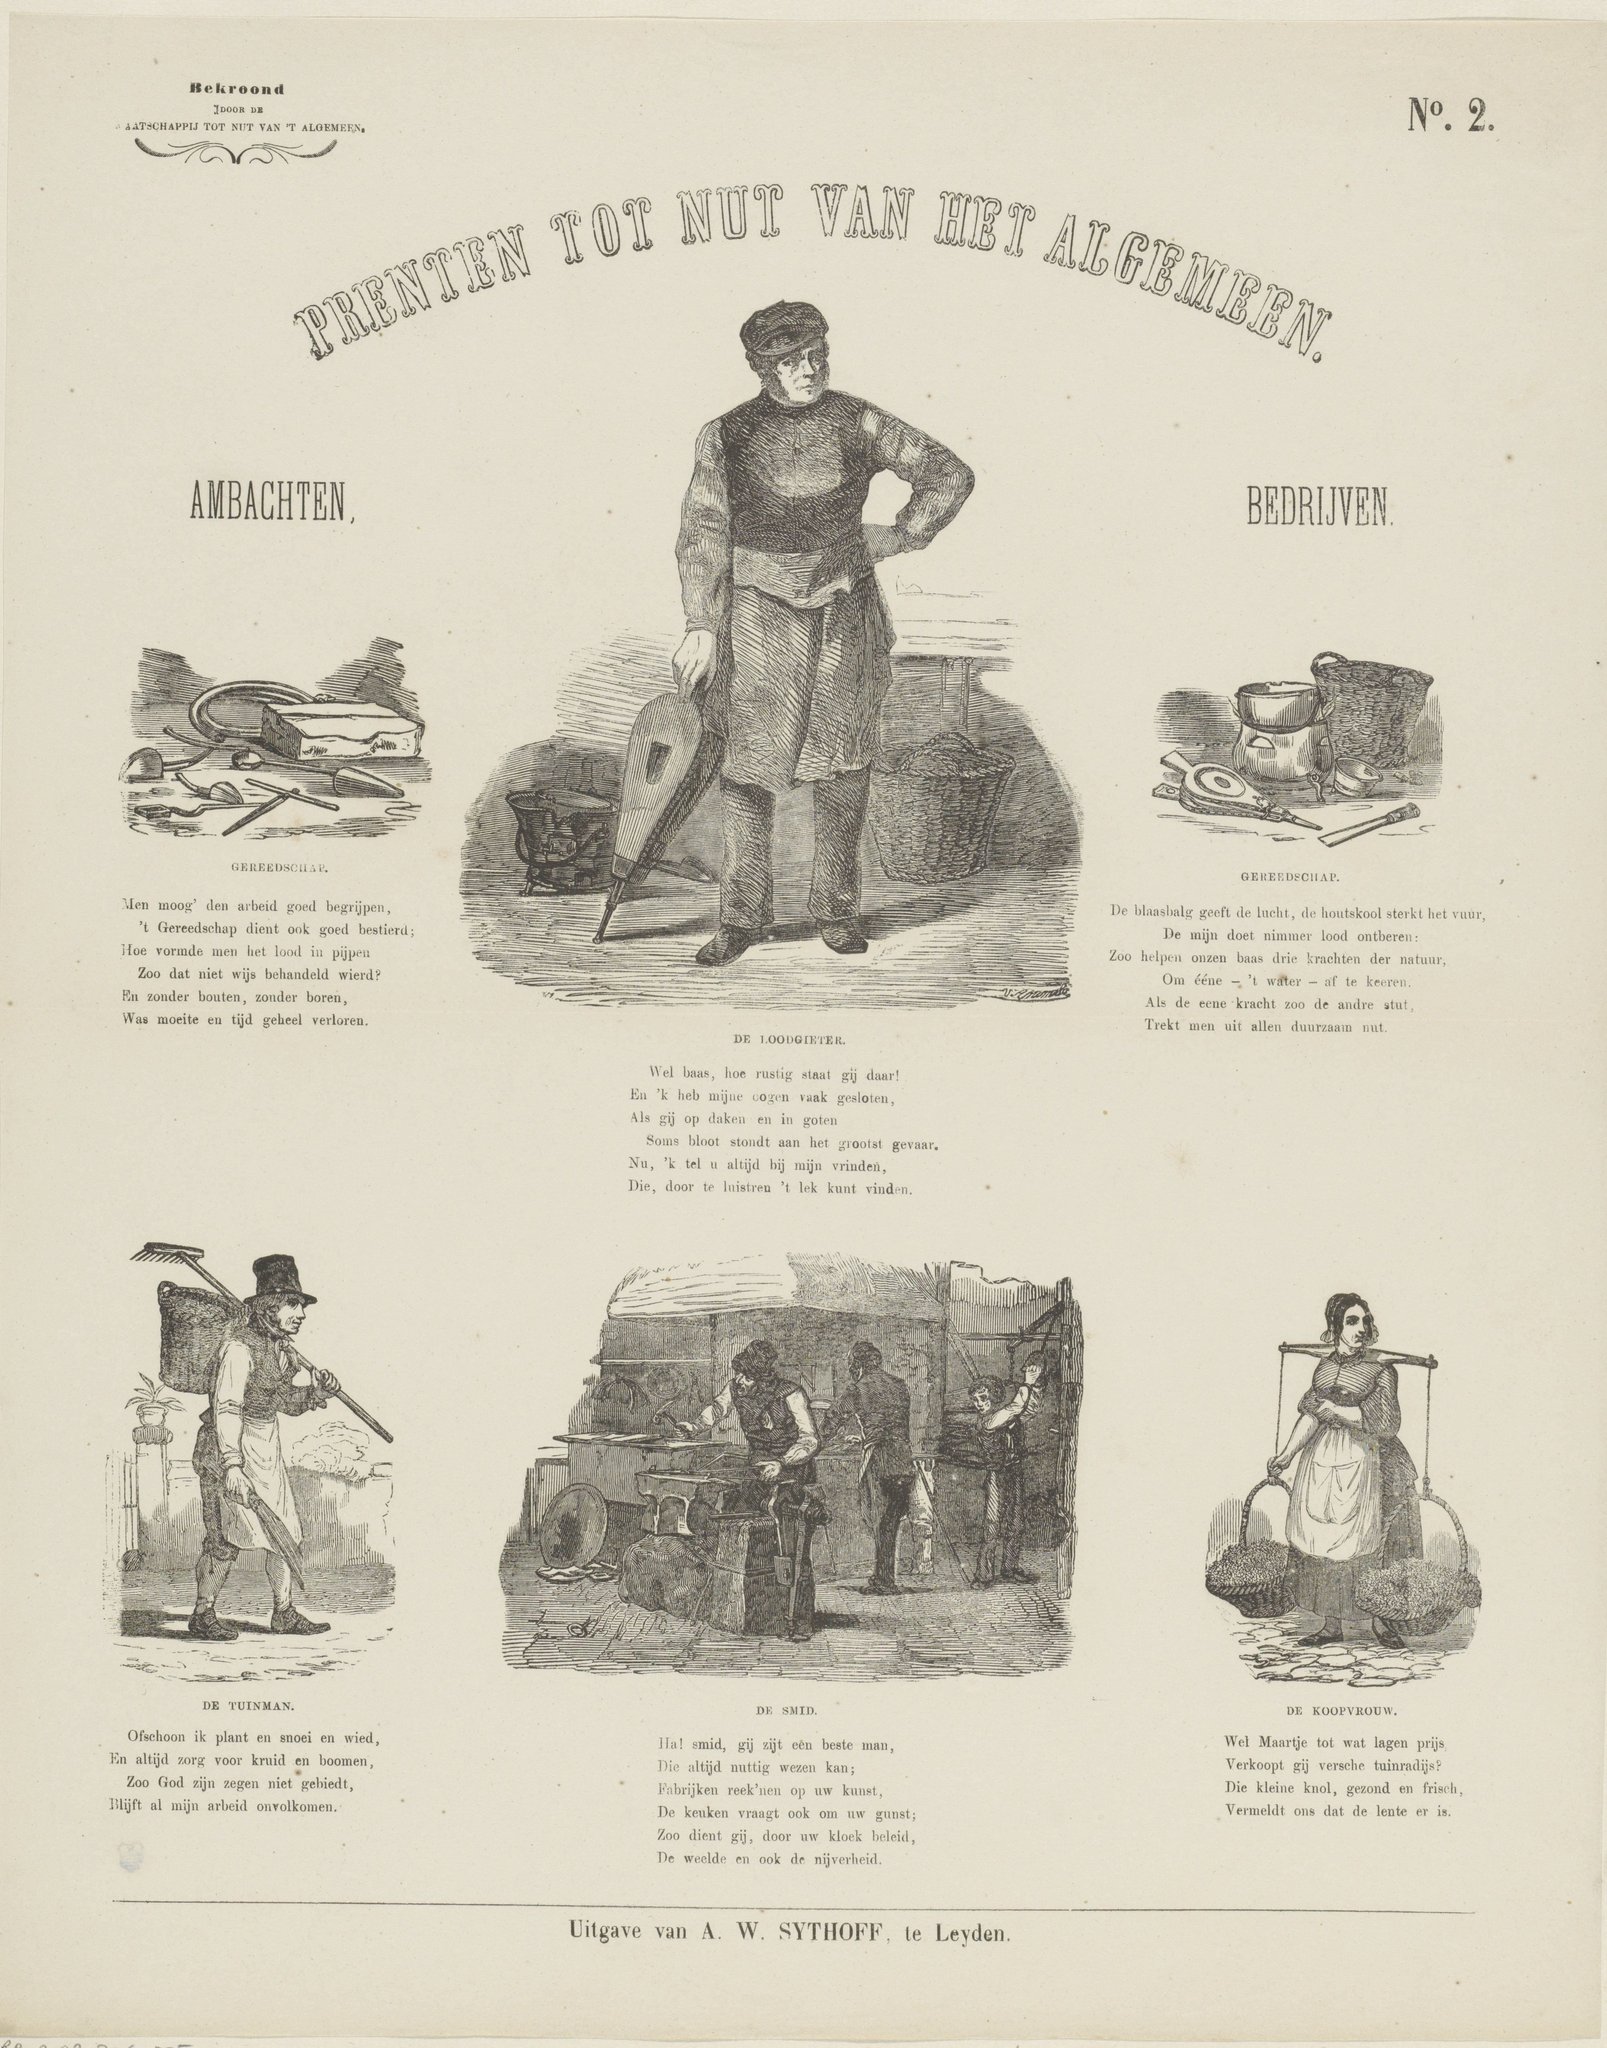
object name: popular print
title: Prenten tot nut van het algemeen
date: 1861-1929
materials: paper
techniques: letterpress printing, engraving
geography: leiden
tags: tools, aids, implements ~ crafts and industries, plumber, street-trader, smith, blacksmith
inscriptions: collector's mark: Lugt 2760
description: Blad met 6 voorstellingen van gereedschap, een loodgieter, een tuinman, een smid en een koopvrouw. Onder elke voorstelling een titel en een vers. Genummerd rechtsboven: No. 2. Linksboven: Bekroond door de Maatschappij tot Nut van 't Algemeen.